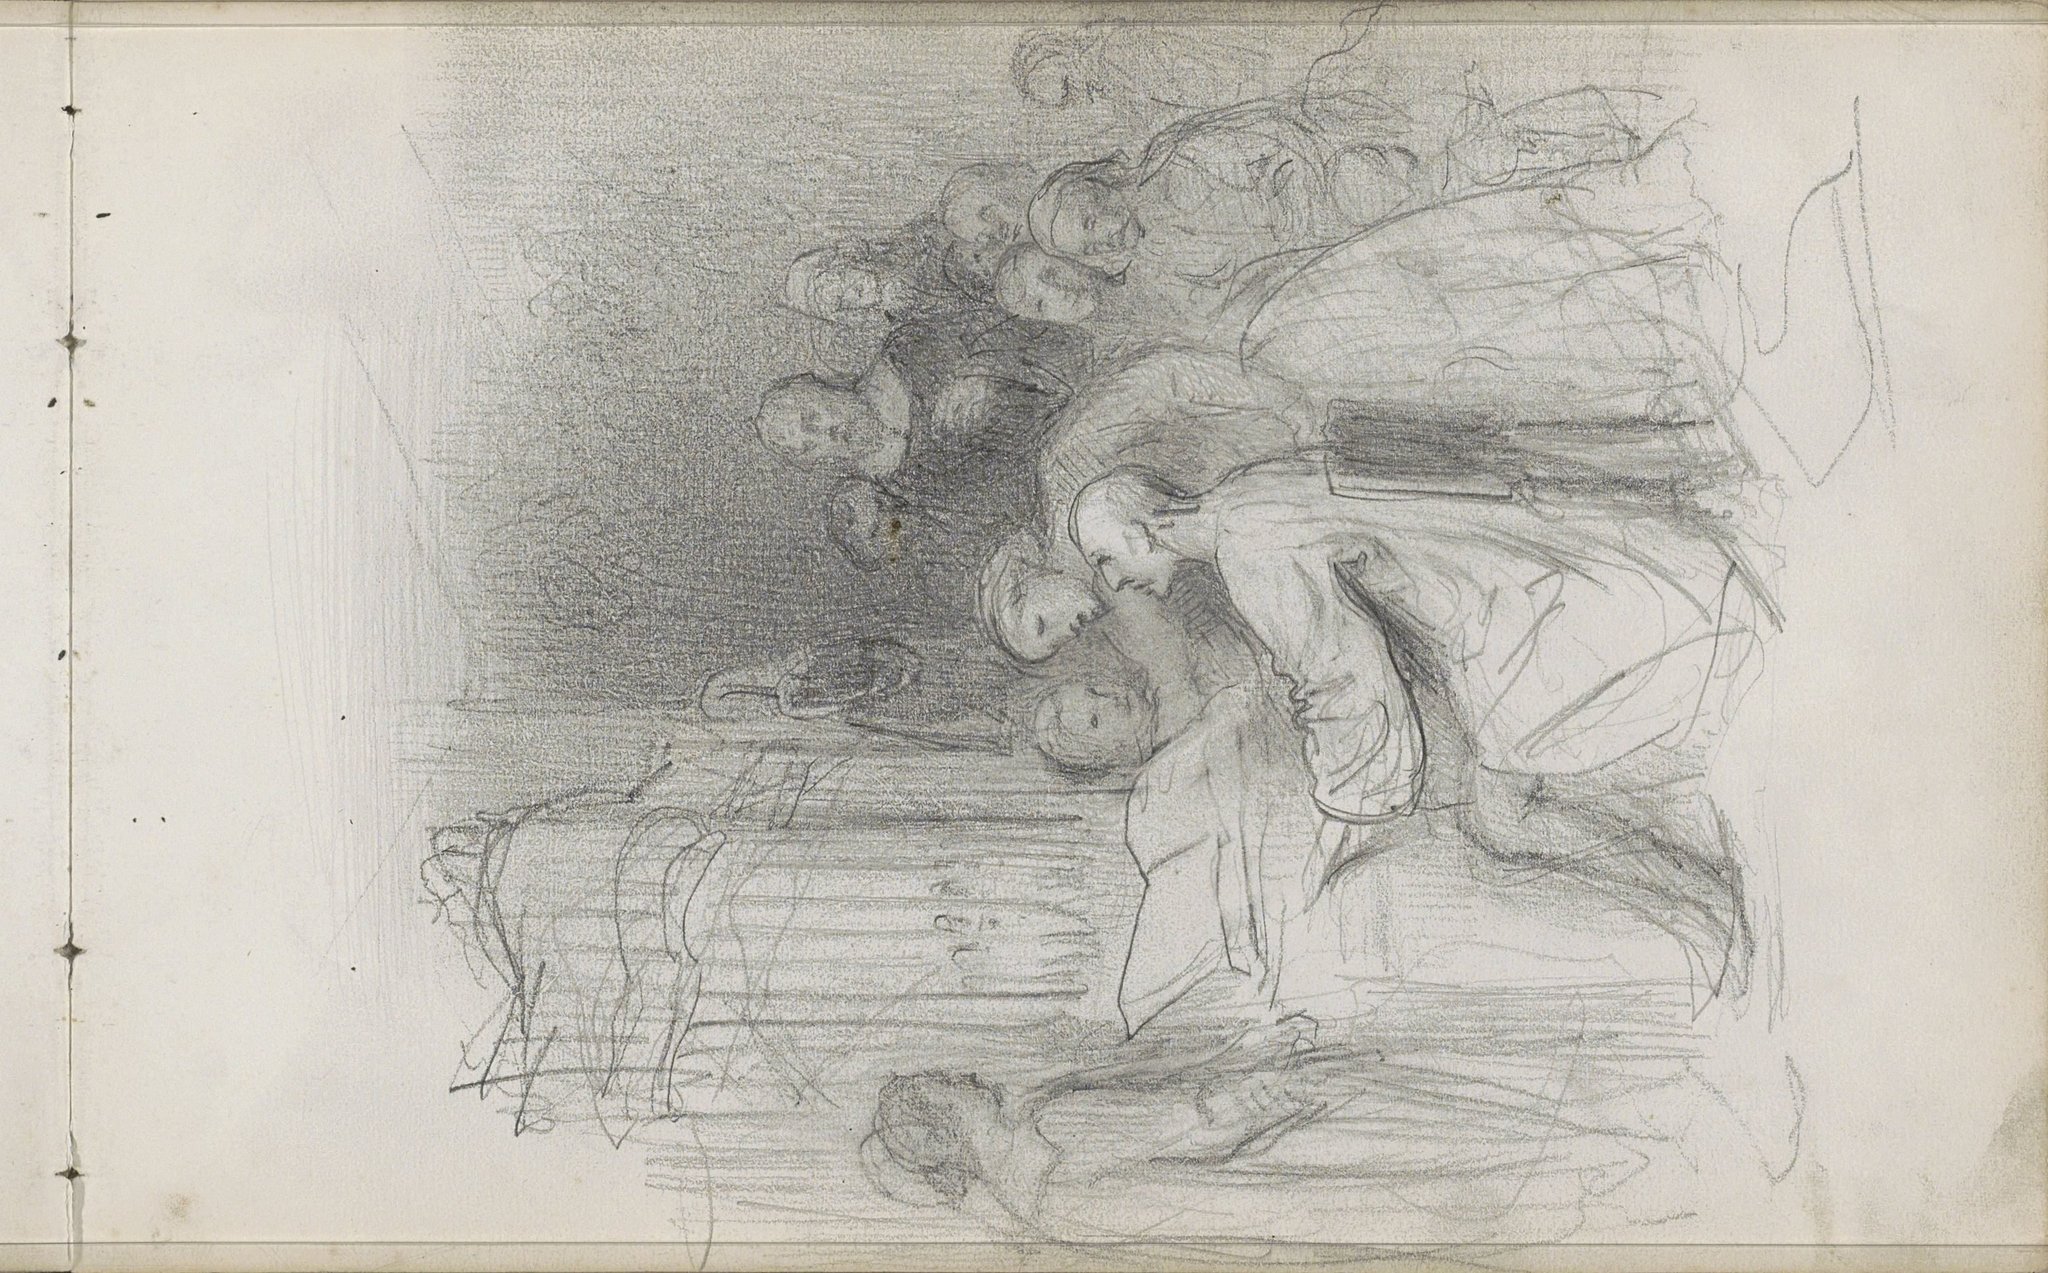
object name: sketchbook leaf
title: Organist met toehoorders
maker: bastiaan de poorter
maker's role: painter, print maker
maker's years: 1813-1880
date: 1858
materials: paper, pencil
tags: organ, the audience ~ art performance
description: Een man zit achter een orgel en speelt in het bijzijn van een gezelschap mannen, vrouwen en kinderen. Eén vrouw slaat de bladmuziek om. Blad 9 recto uit een gecombineerd album amicorum en schetsboek met in totaal 39 bladen.